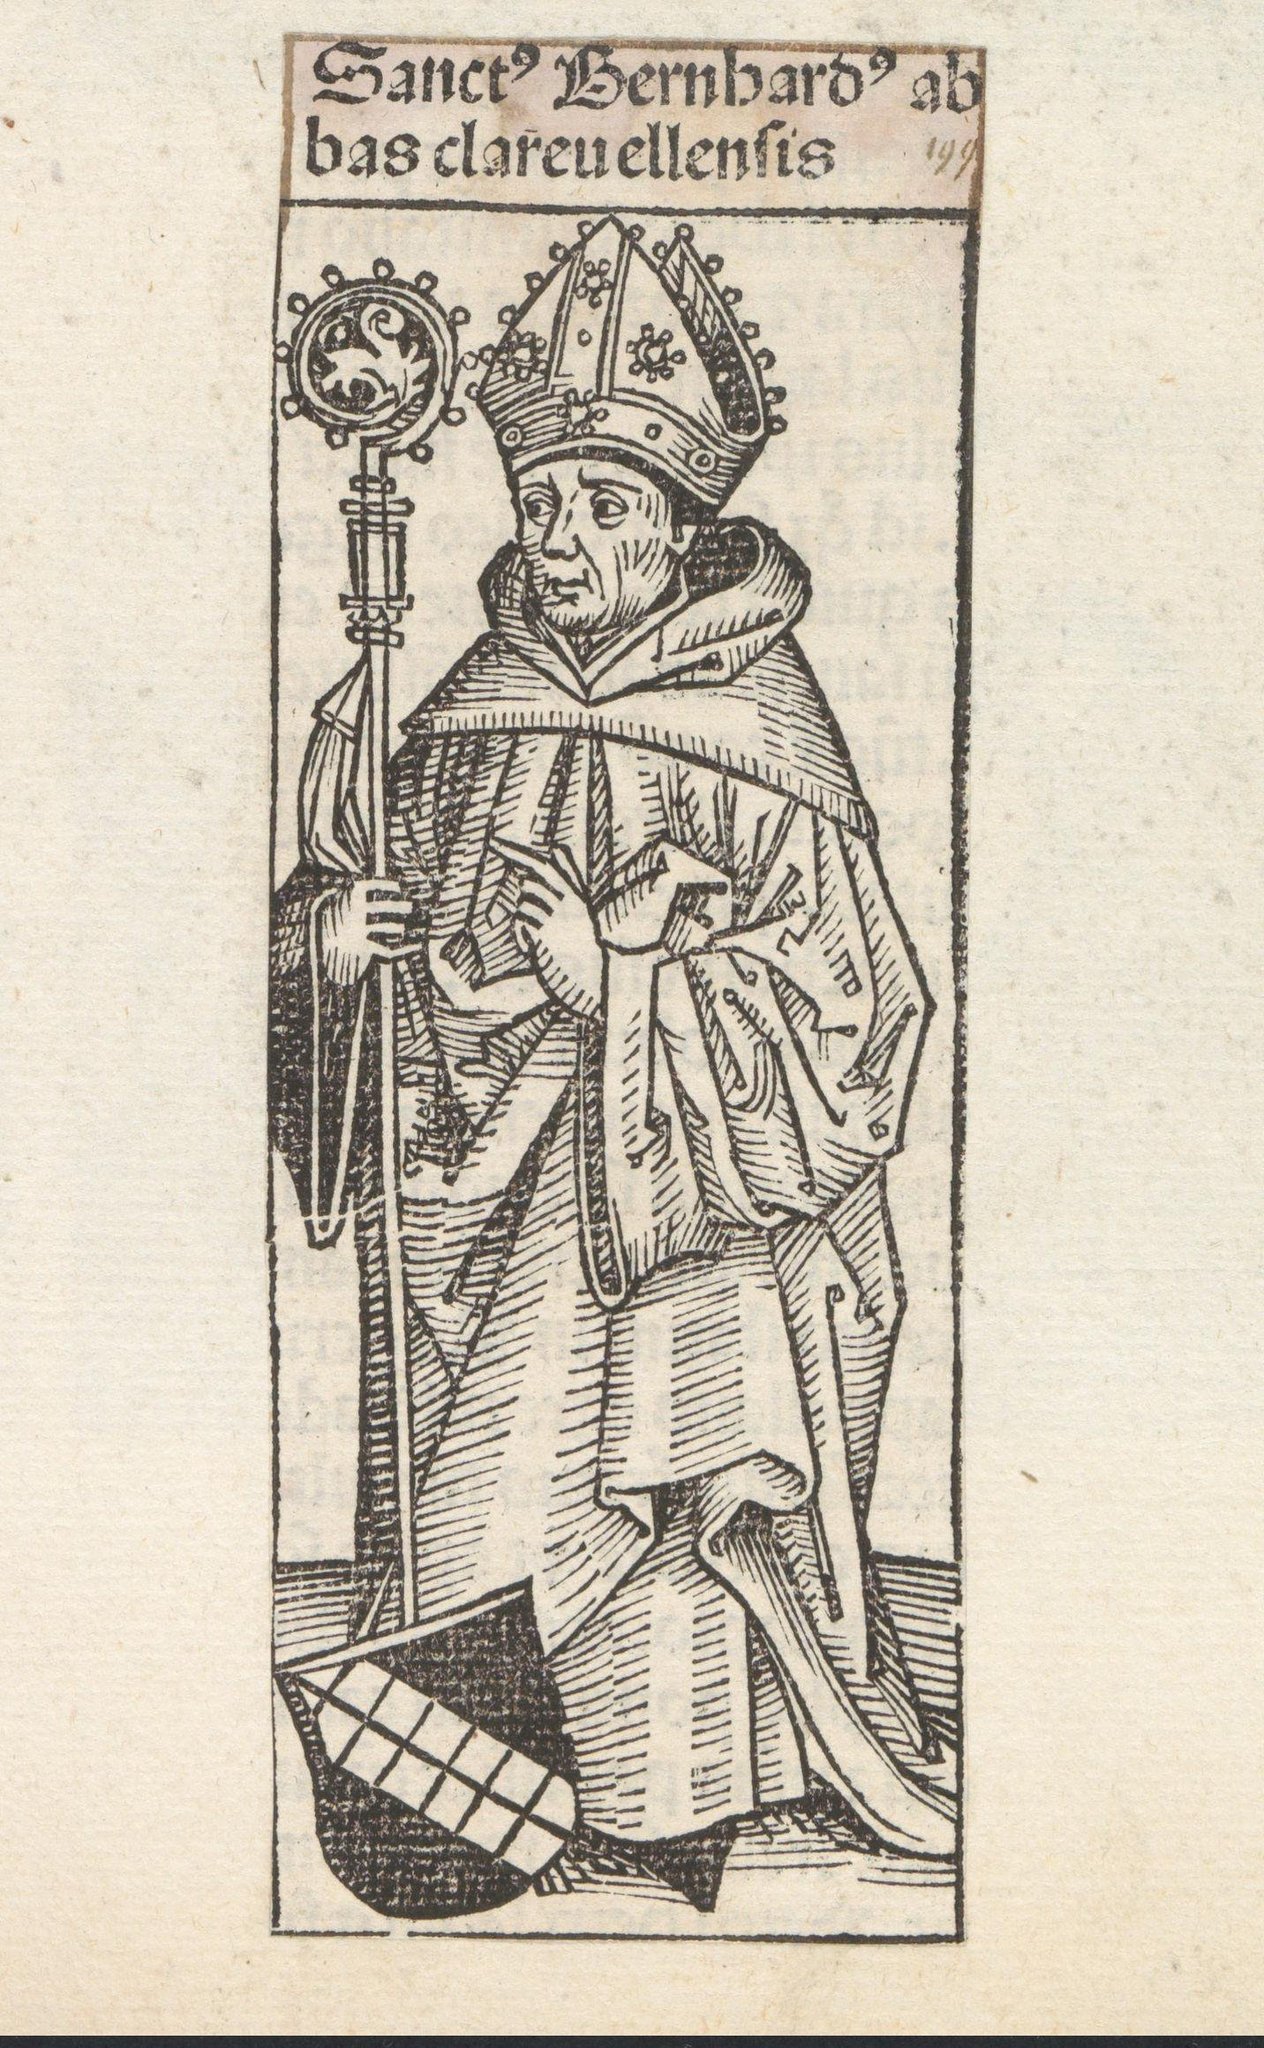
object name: book illustration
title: Liber Chronicarum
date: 1493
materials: paper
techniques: letterpress printing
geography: nuremberg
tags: bernardus van clairvaux, archbishop, bishop, etc. (roman catholic), bernard of clairvaux, cistercian monk and abbot; possible attributes: beehive, chained dragon, crucifix, cross with instruments of the passion, (three) mitre at his feet, white dog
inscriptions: inscription: ‘199’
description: Een bisschop, ten voeten uit. Hij heeft een kromstaf in zijn handen en bij zijn voeten een wapenschild. De tekst identificeert de man als de heilige Bernardus van Clairvaux. De prent maakt deel uit van een album.